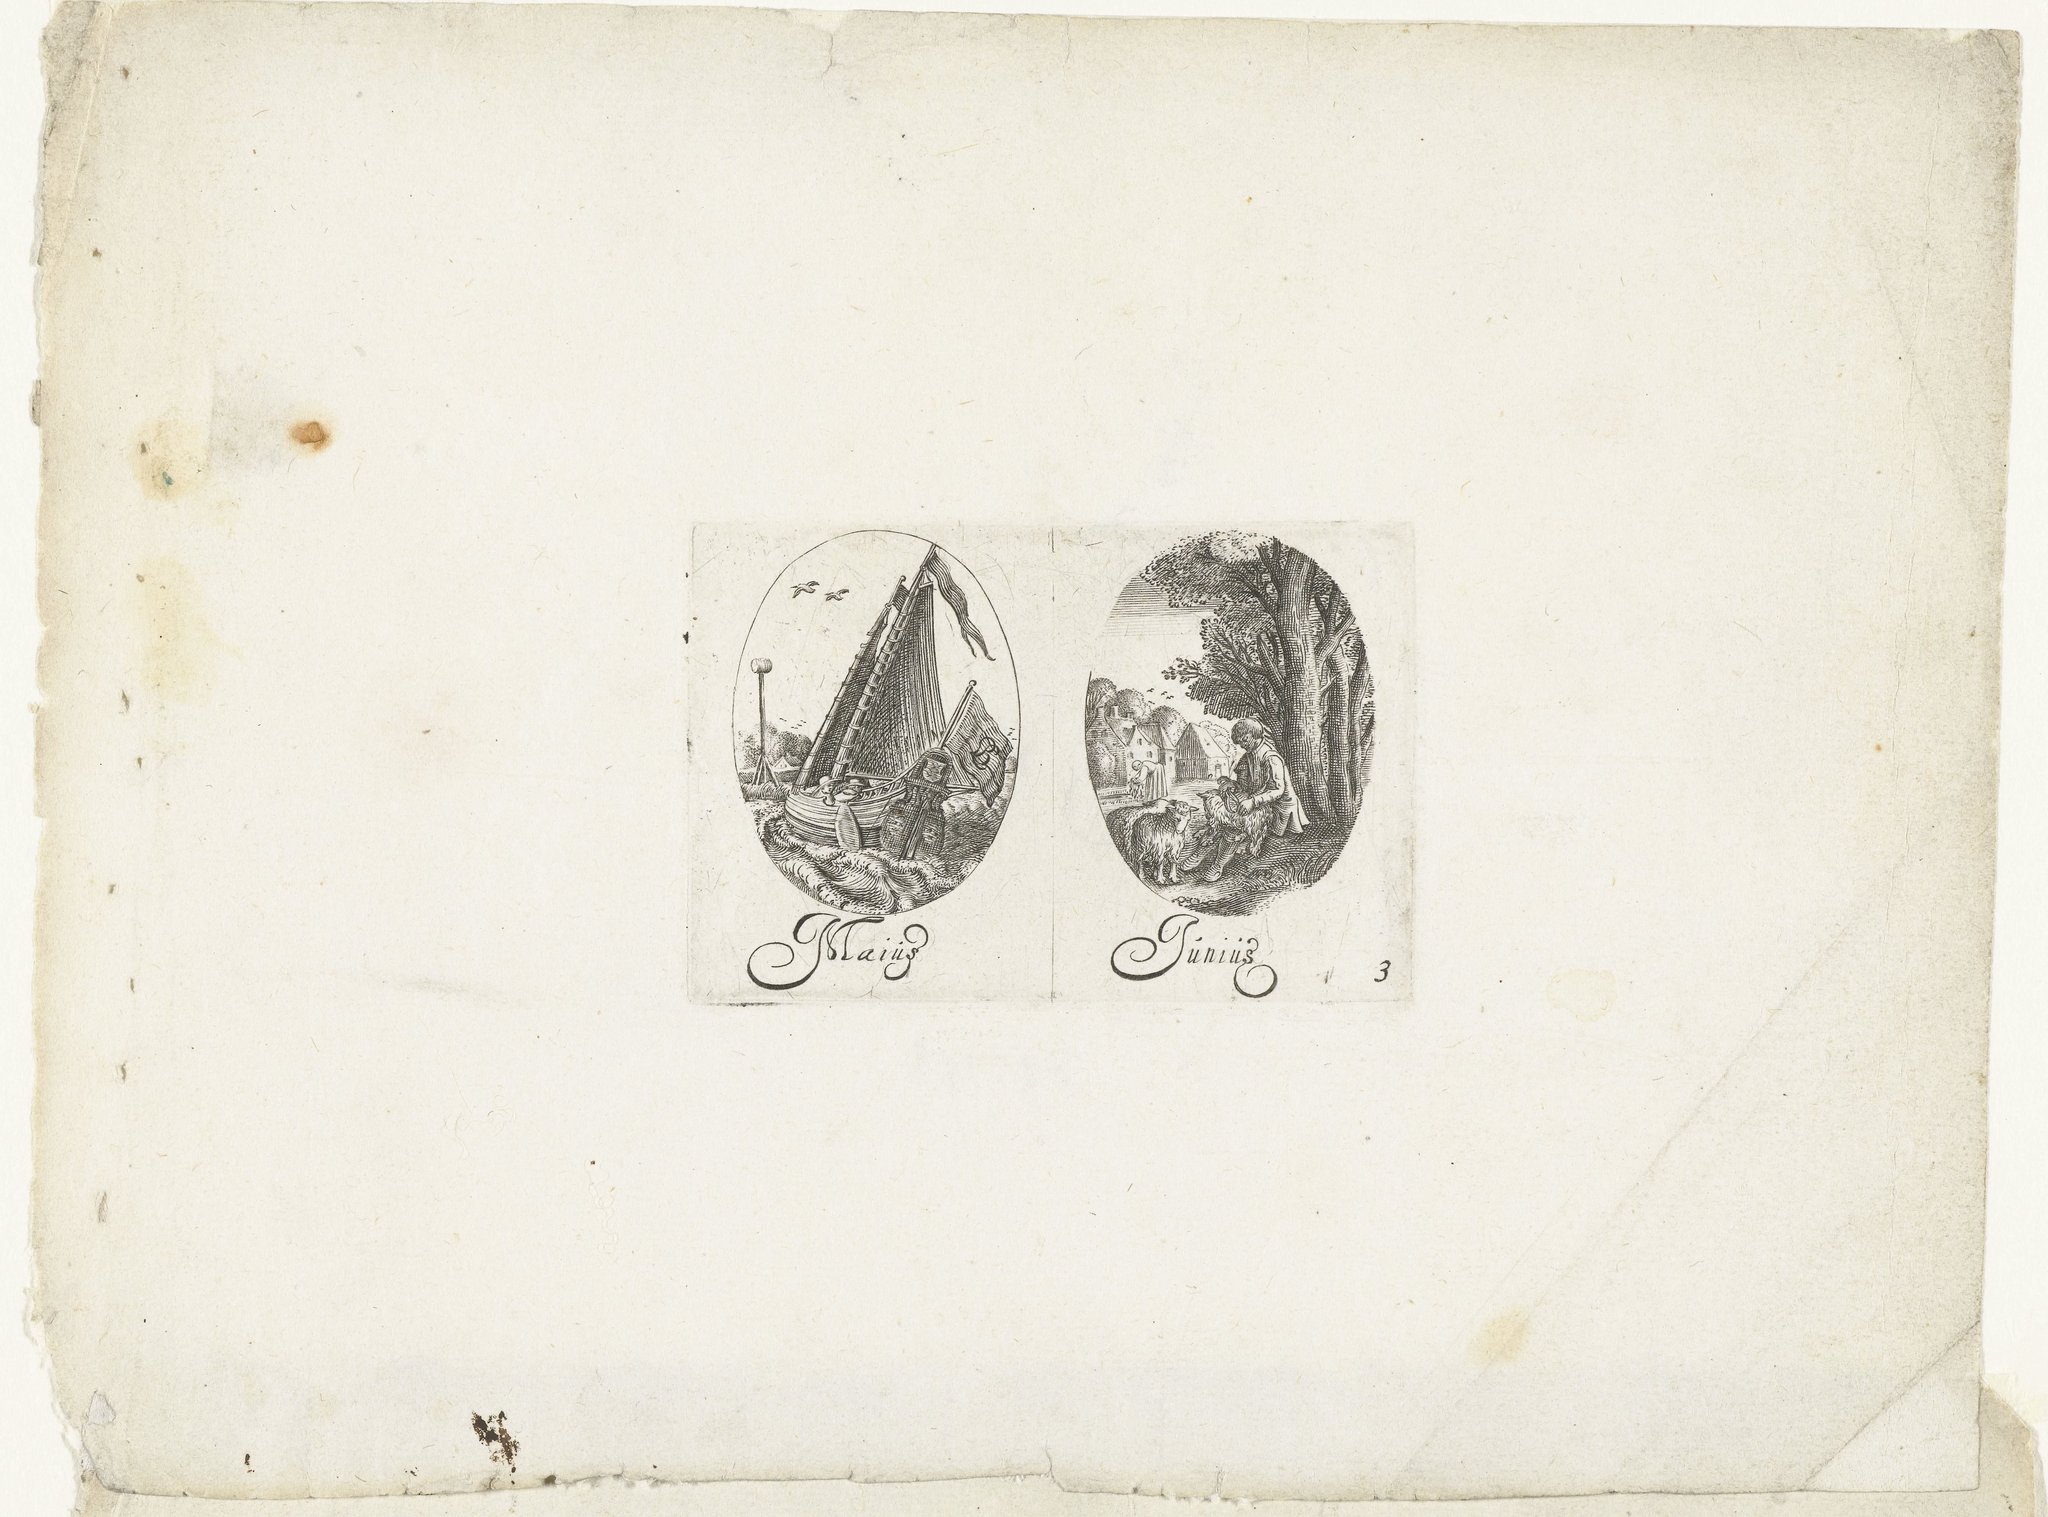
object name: ornament print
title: Maanden van het jaar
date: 1630-1635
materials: paper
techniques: engraving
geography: amsterdam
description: De maand mei: een zeilbootje. De maand juni: het scheren van schapen.